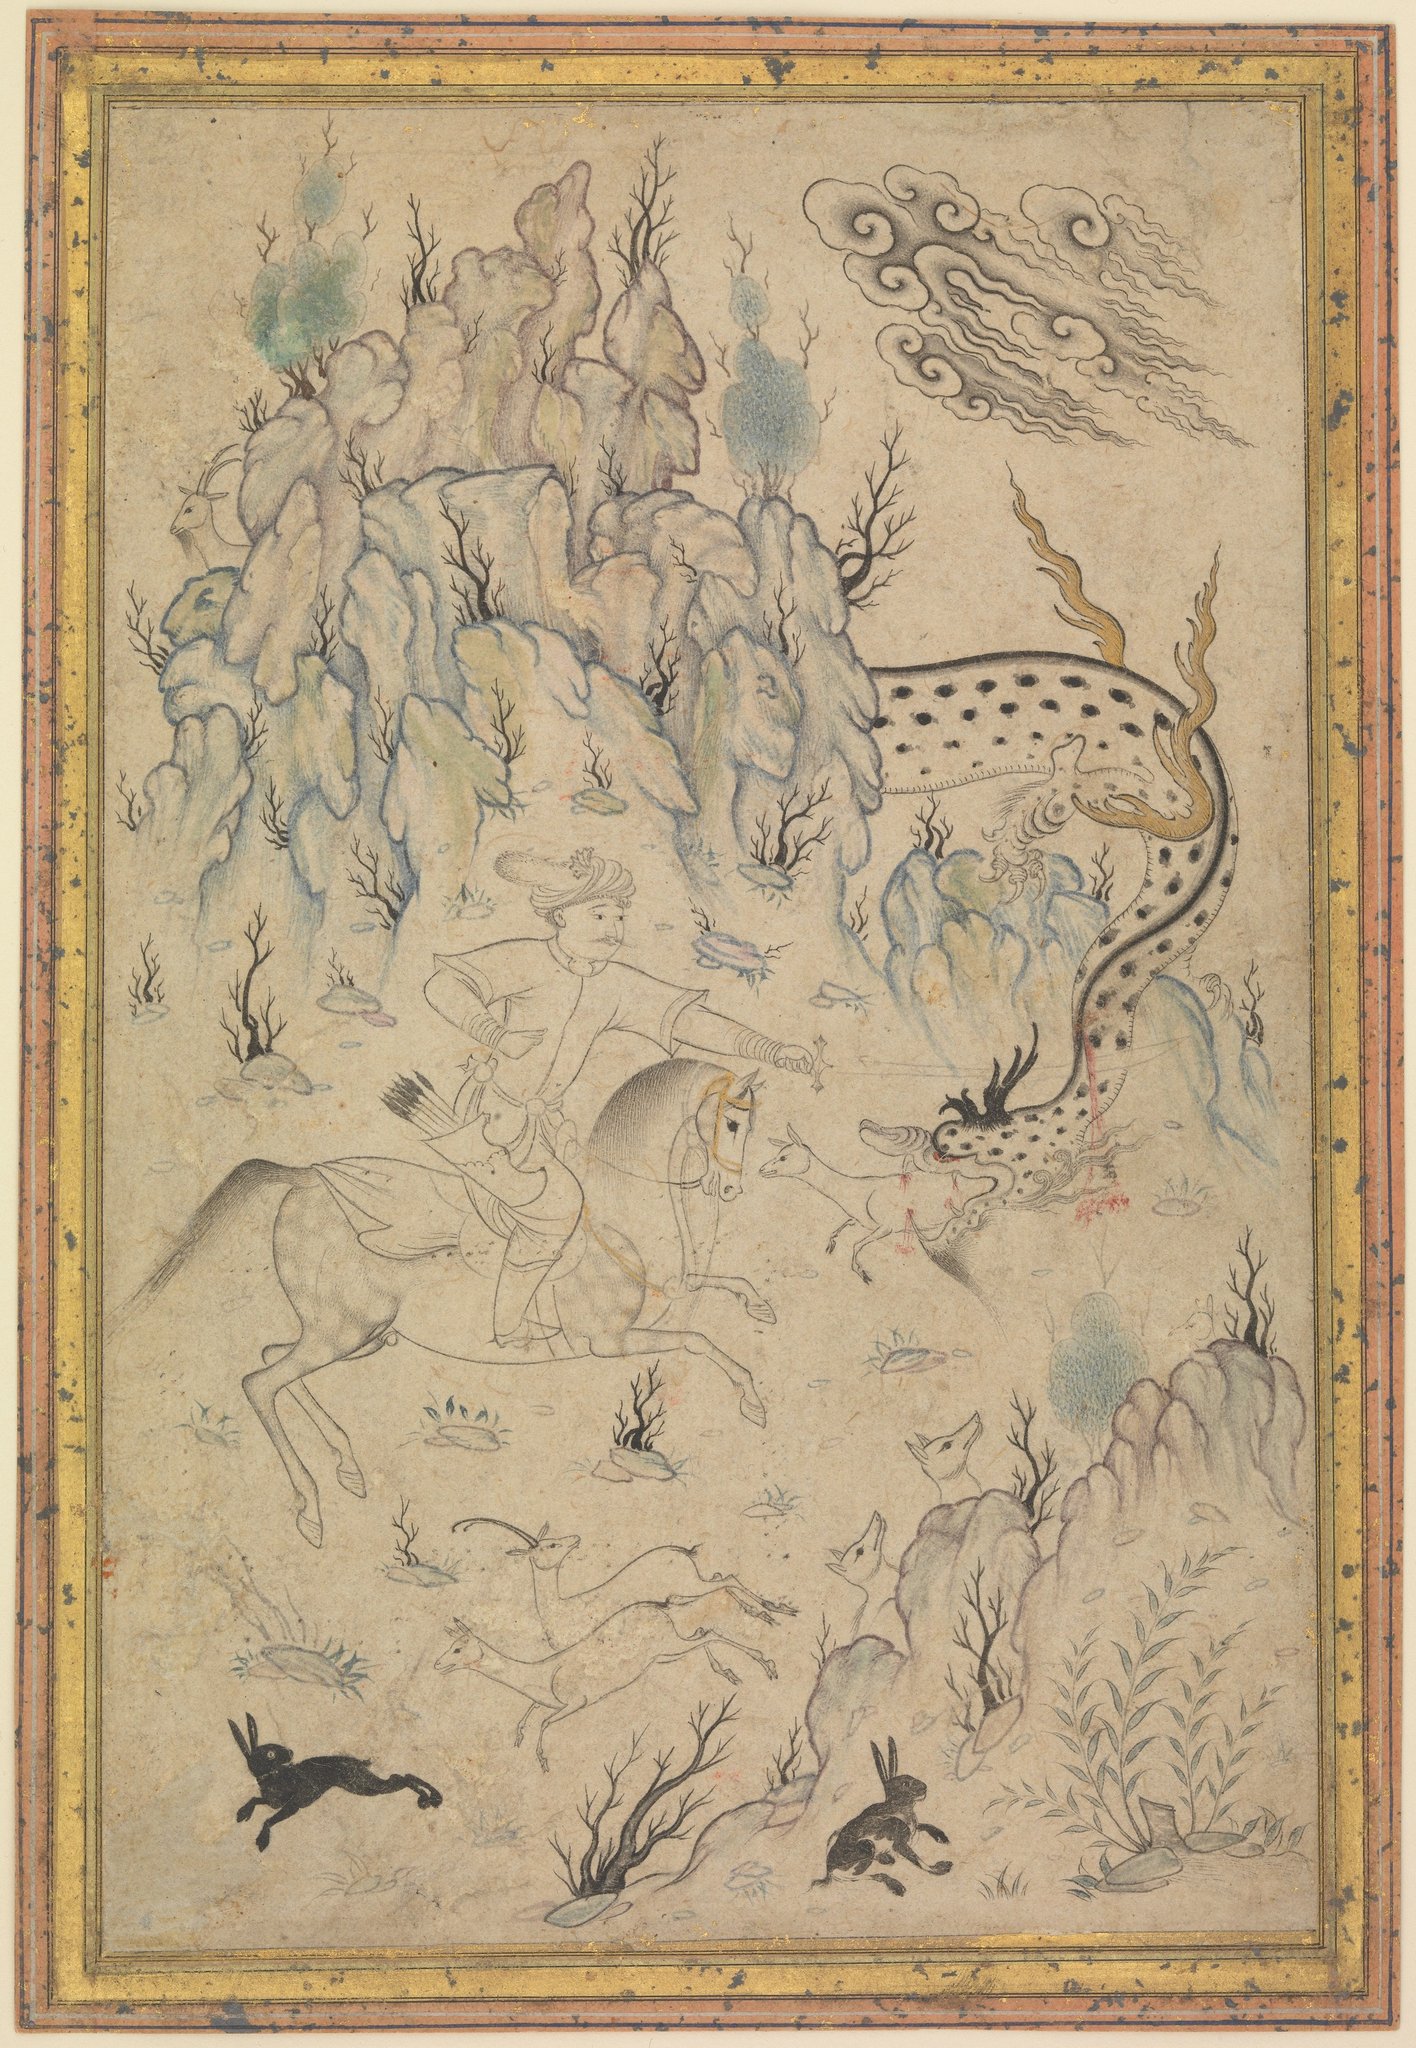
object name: illustrated single work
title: Hero and Dragon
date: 1551-1575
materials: gold, ink, paper, watercolor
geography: iran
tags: animals,men,dragons,horses